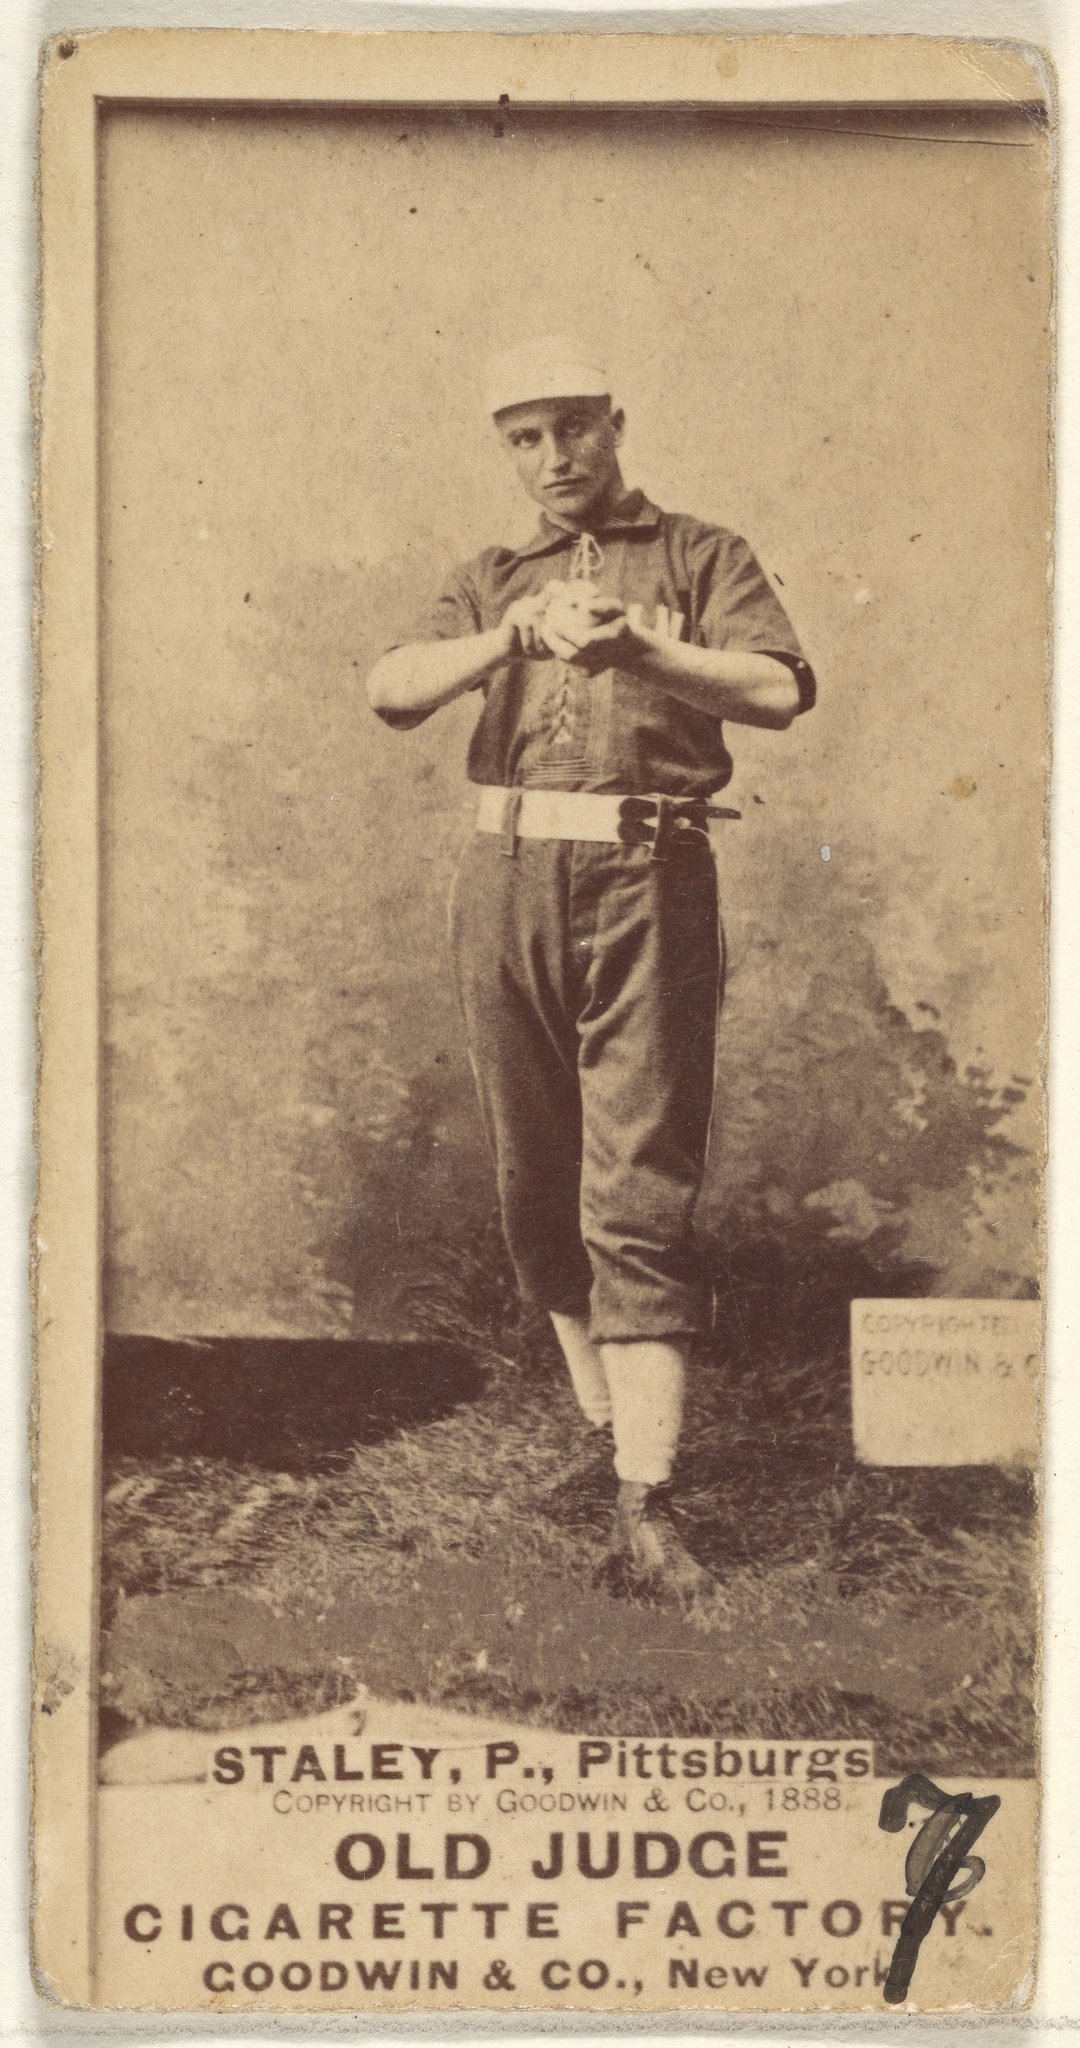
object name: baseball card, photograph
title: Henry "Harry" Eli Staley, Pitcher, Pittsburgh, from the Old Judge series (N172) for Old Judge Cigarettes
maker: goodwin & company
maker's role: publisher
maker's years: 1850-1950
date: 1888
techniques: albumen silver print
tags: men,portraits,baseball,athletes